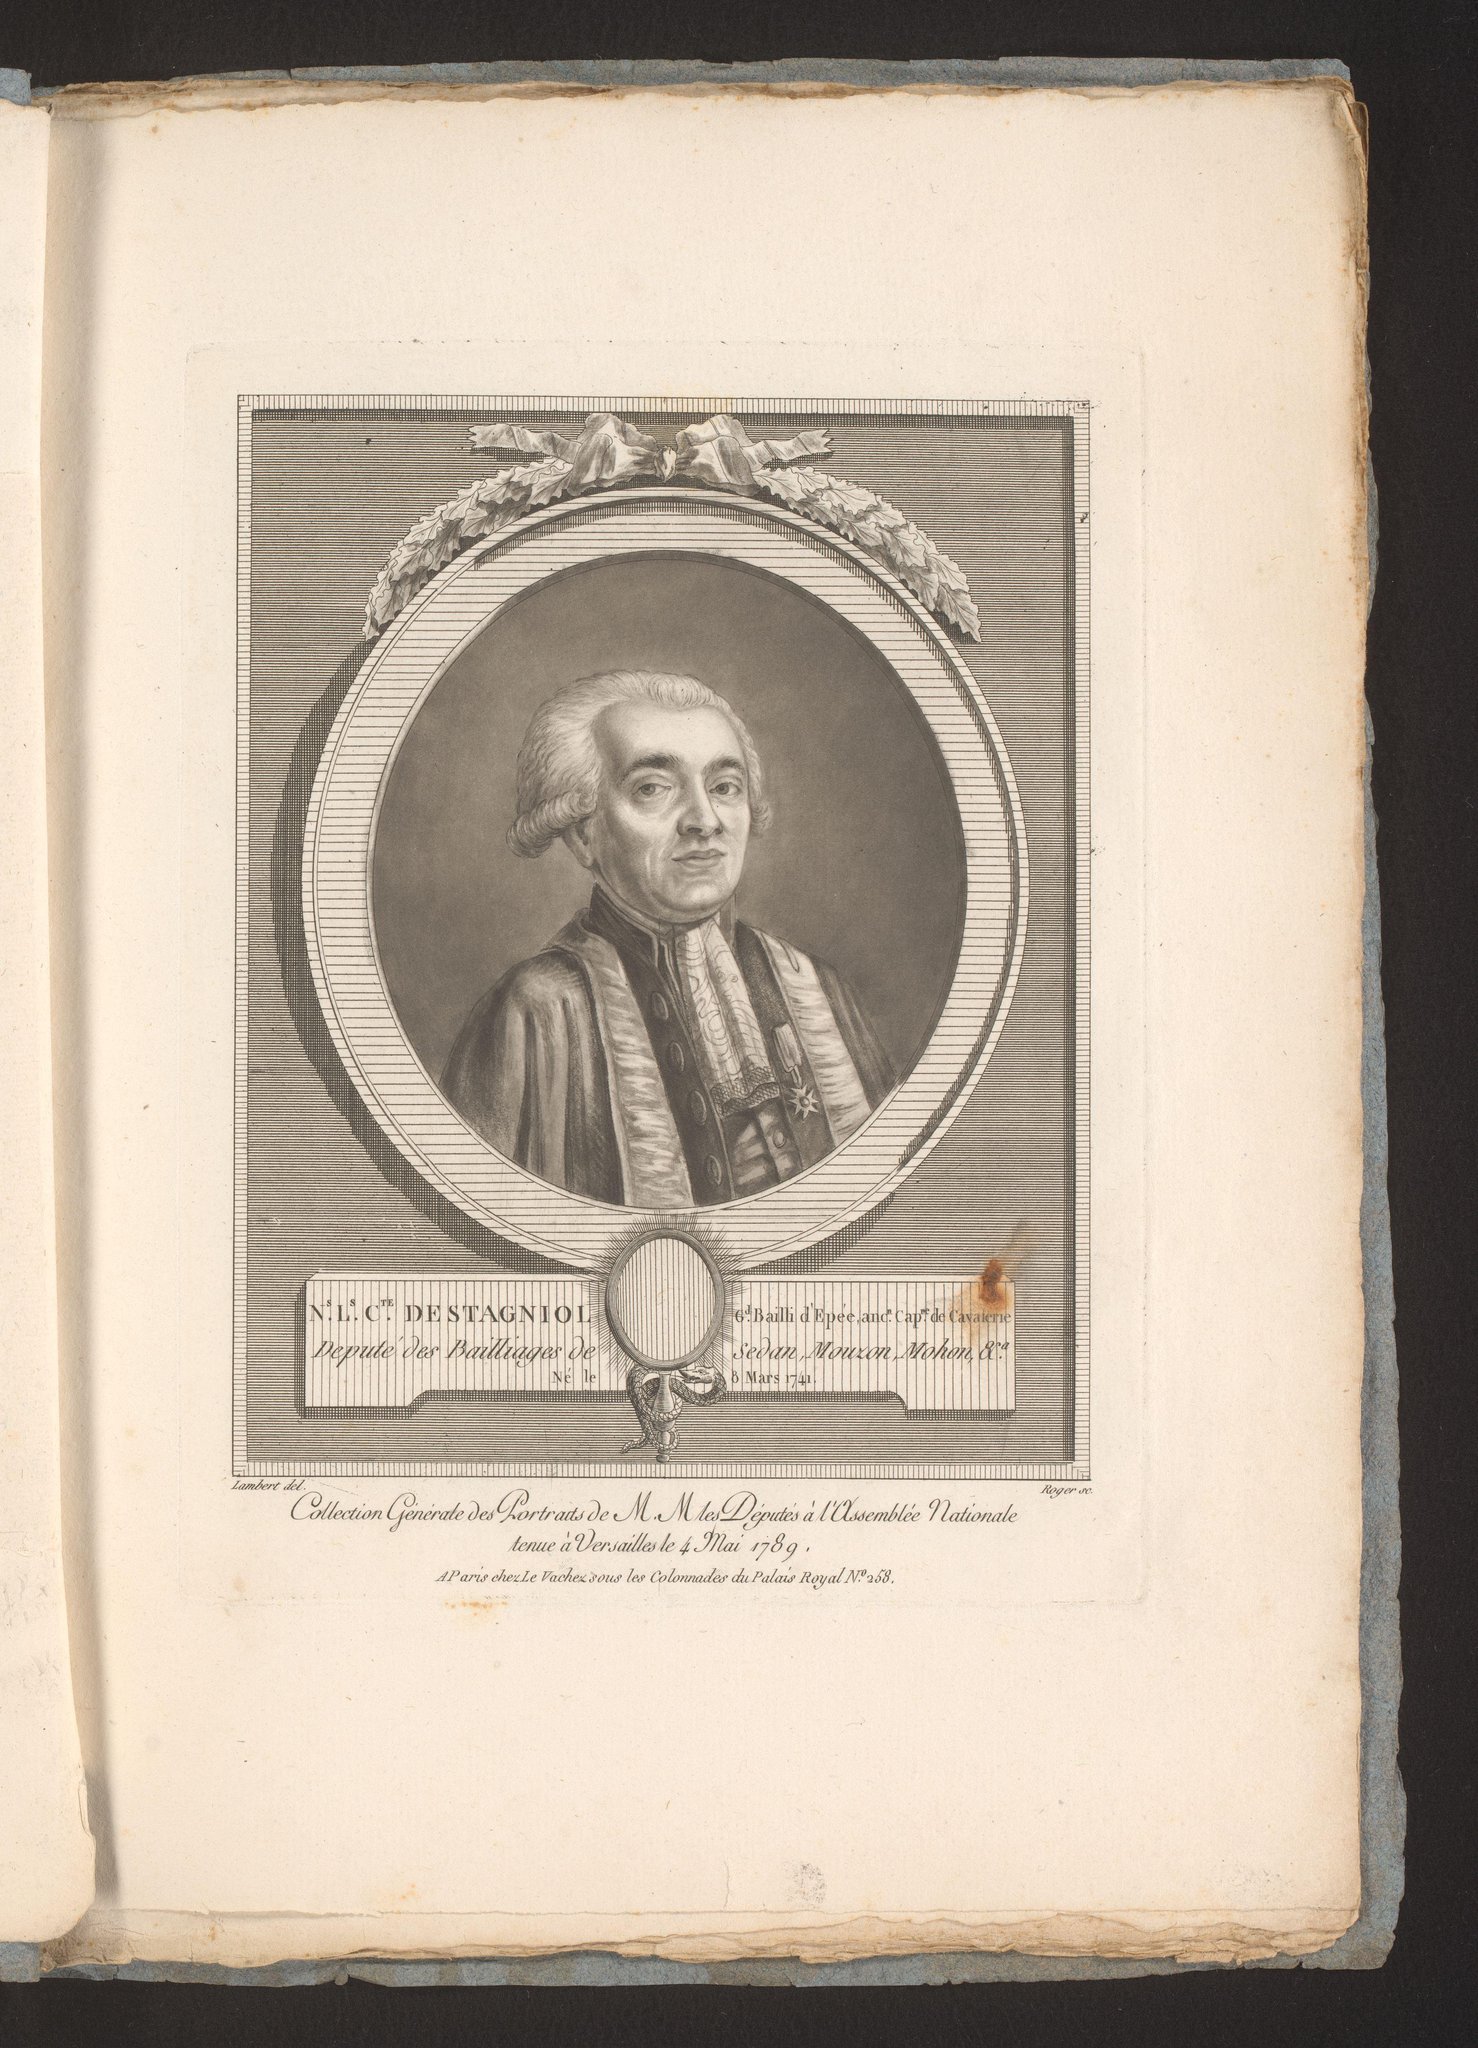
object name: print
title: Portretten van afgevaardigden aanwezig bij de vergadering van de Staten-Generaal op 4 mei 1789 te Versailles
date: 1790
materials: paper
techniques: aquatint, etching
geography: paris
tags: historical persons, politics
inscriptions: collector's mark: Lugt 2228, collector's mark: Lugt 2760